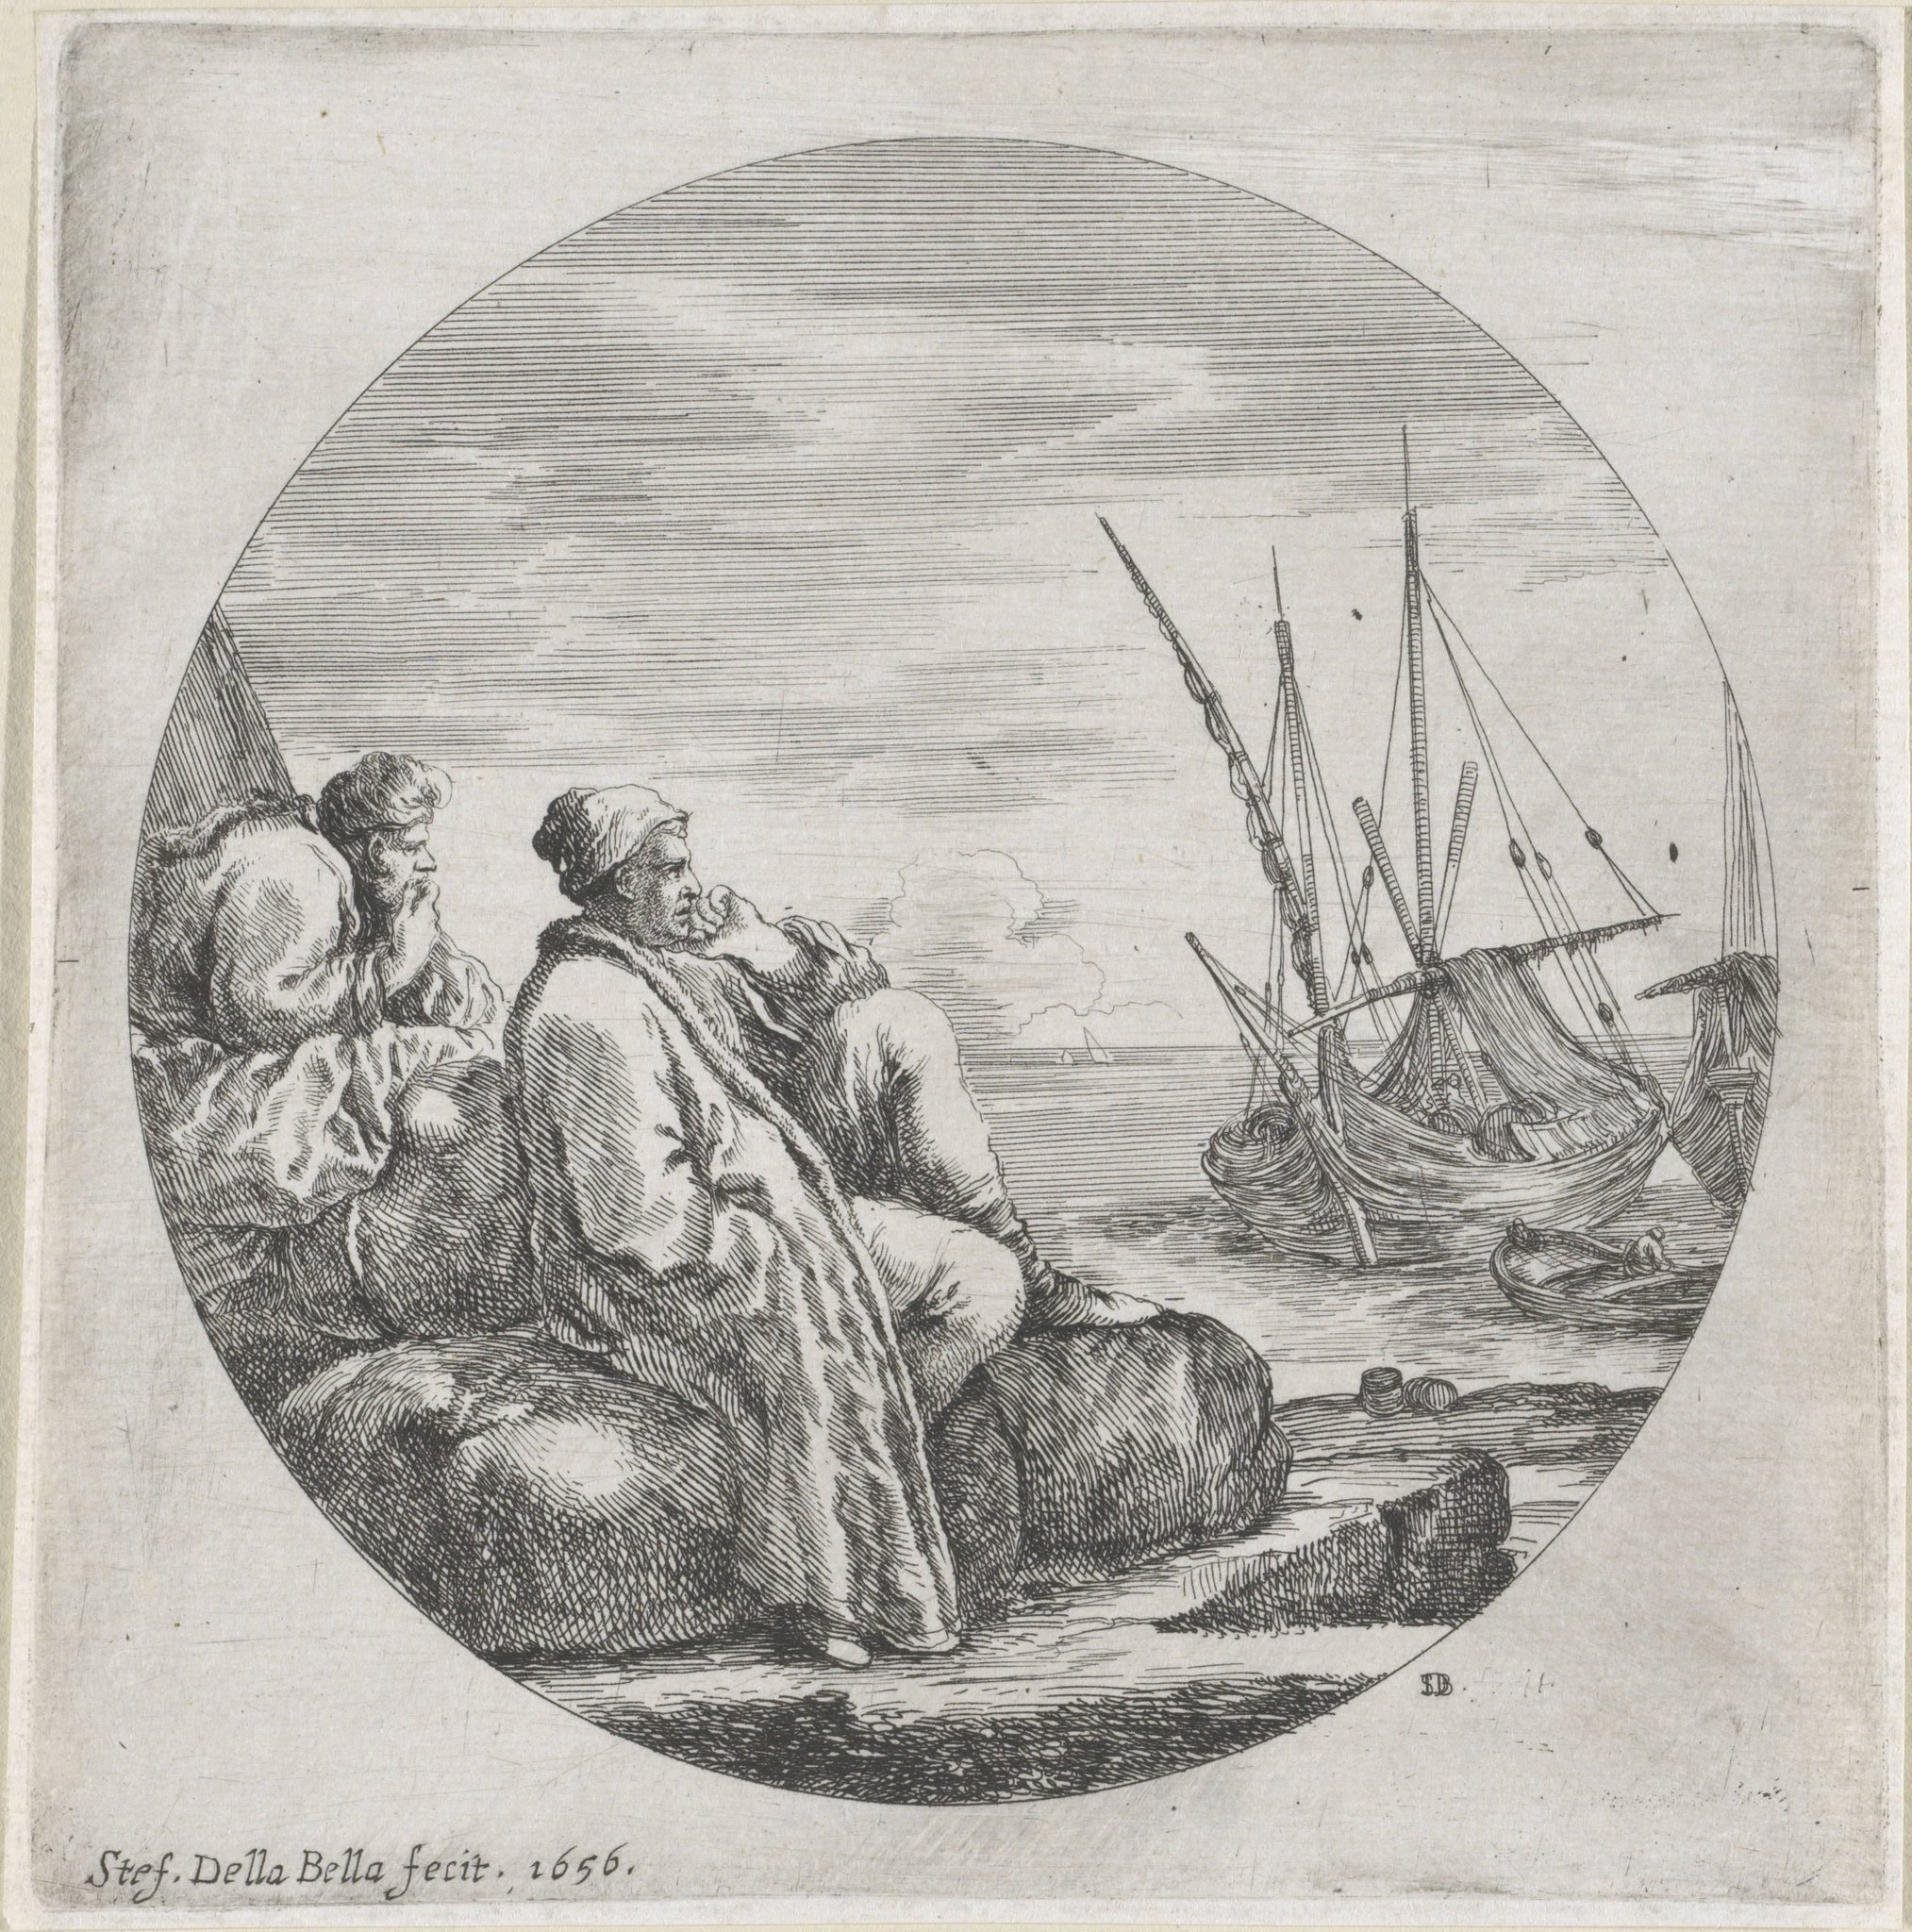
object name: print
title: Twee Turkse handelaren op de kade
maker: stefano della bella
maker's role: draughtsman, print maker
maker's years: 1610-1664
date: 1656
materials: paper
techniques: etching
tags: harbour, asiatic races and peoples: turks, ships (in general) - cc - more than one ship, merchant, salesman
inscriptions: collector's mark: Lugt 240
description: Twee Turkse handelaren kijken naar schepen op zee terwijl zij op de kade zitten te rusten.